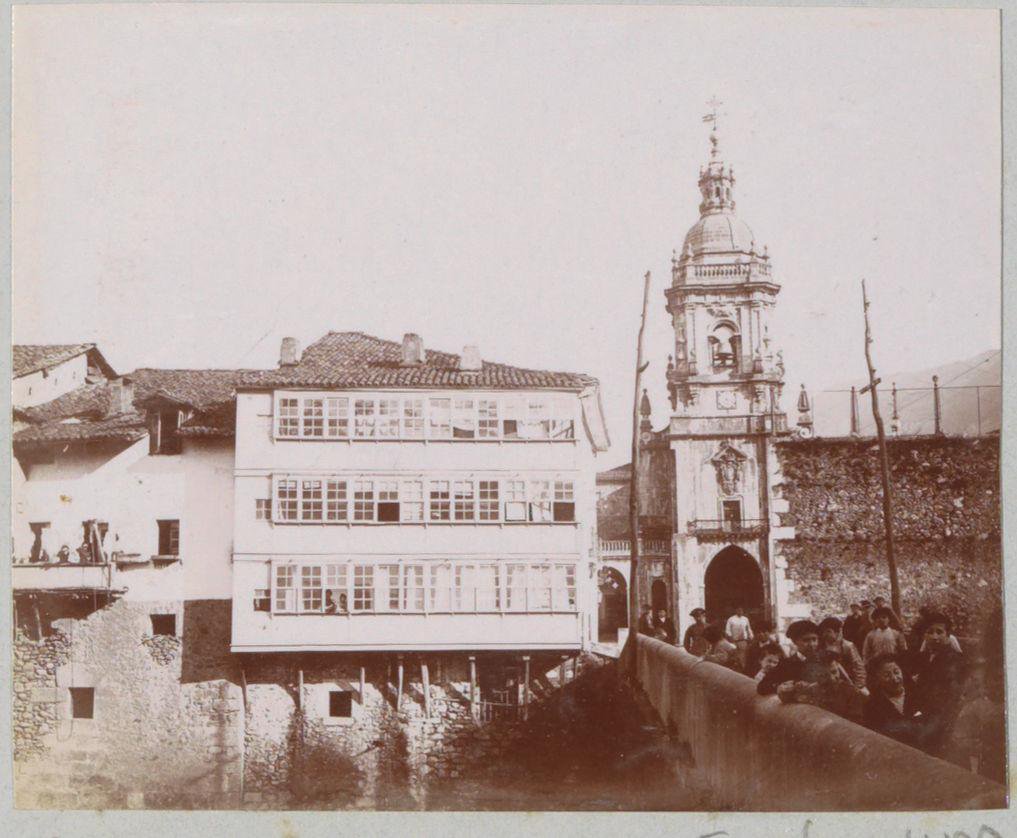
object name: photograph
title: Gezicht op Elgoibar met rechts de kerk van San Bartolomé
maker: delizy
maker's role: manufacturer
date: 1904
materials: paper, photographic support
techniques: gelatin silver print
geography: elgoibar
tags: cattle, farmers, road, path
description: Onderdeel van Fotoalbum van een Franse amateurfotograaf met opnames van uitstapjes in Frankrijk, Spanje, België, Luxemburg en Nederland, de eerste automobielen en autoraces.